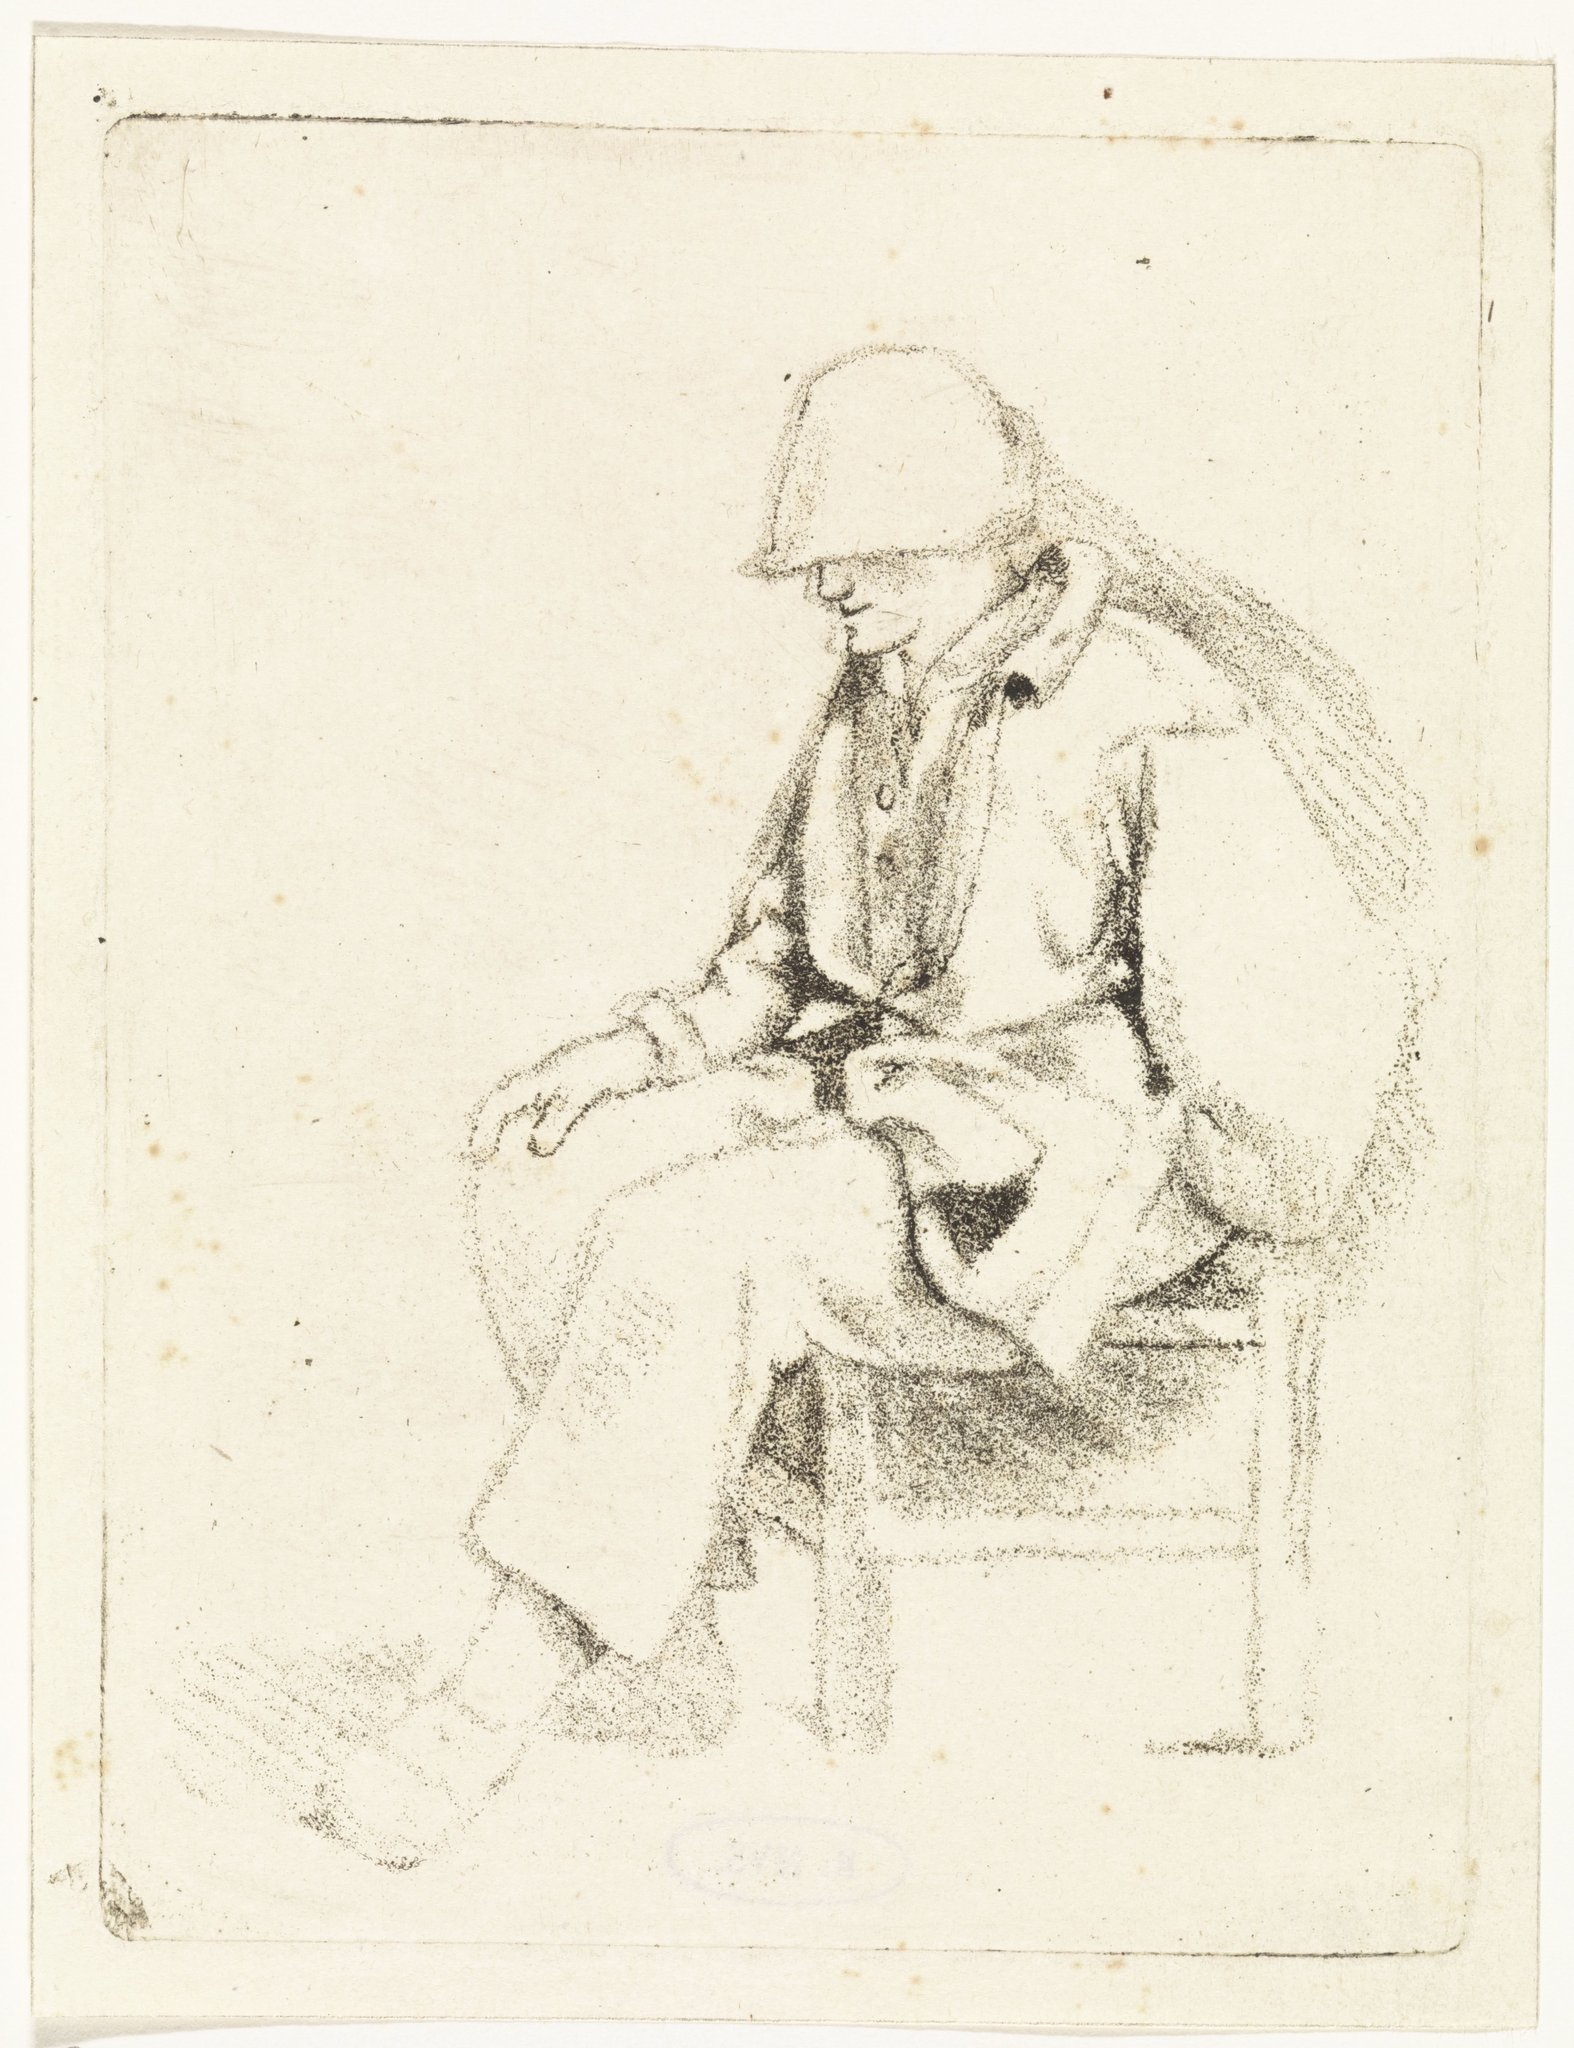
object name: print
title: Zittende man met muts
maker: johannes huibert prins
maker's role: draughtsman, painter, print maker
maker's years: 1757-1806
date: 1783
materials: paper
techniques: printmaking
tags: sitting figure, head-gear: cap (+ men's clothes)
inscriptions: collector's mark: Lugt 2228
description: Op een kruk zit een man met muts op en jas aan. Zijn hand rust op zijn knie, zijn muts is diep over zijn ogen getrokken.